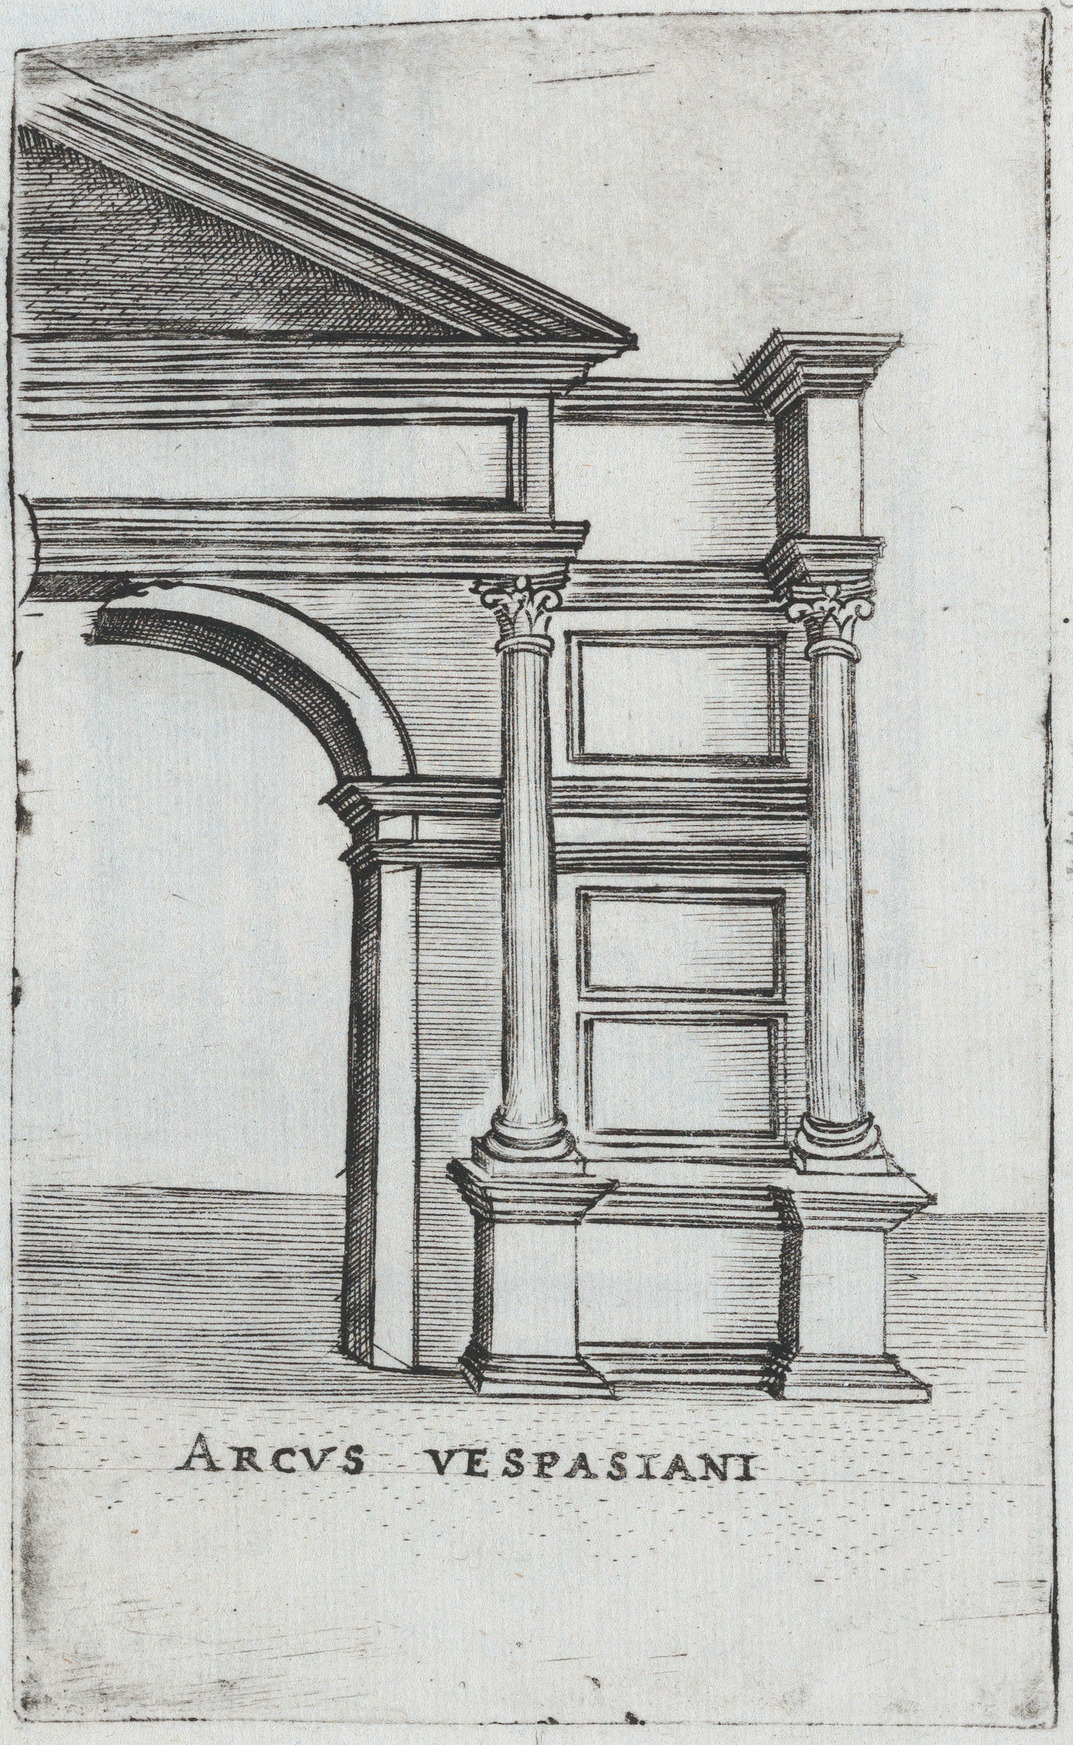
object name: album print ornament architecture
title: Palatium M. Agrippa, from a Series of Prints depicting (reconstructed) Buildings from Roman Antiquity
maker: monogrammist g.a. with the caltrop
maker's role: artist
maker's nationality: italian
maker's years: 1535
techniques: engraving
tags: architecture,arches